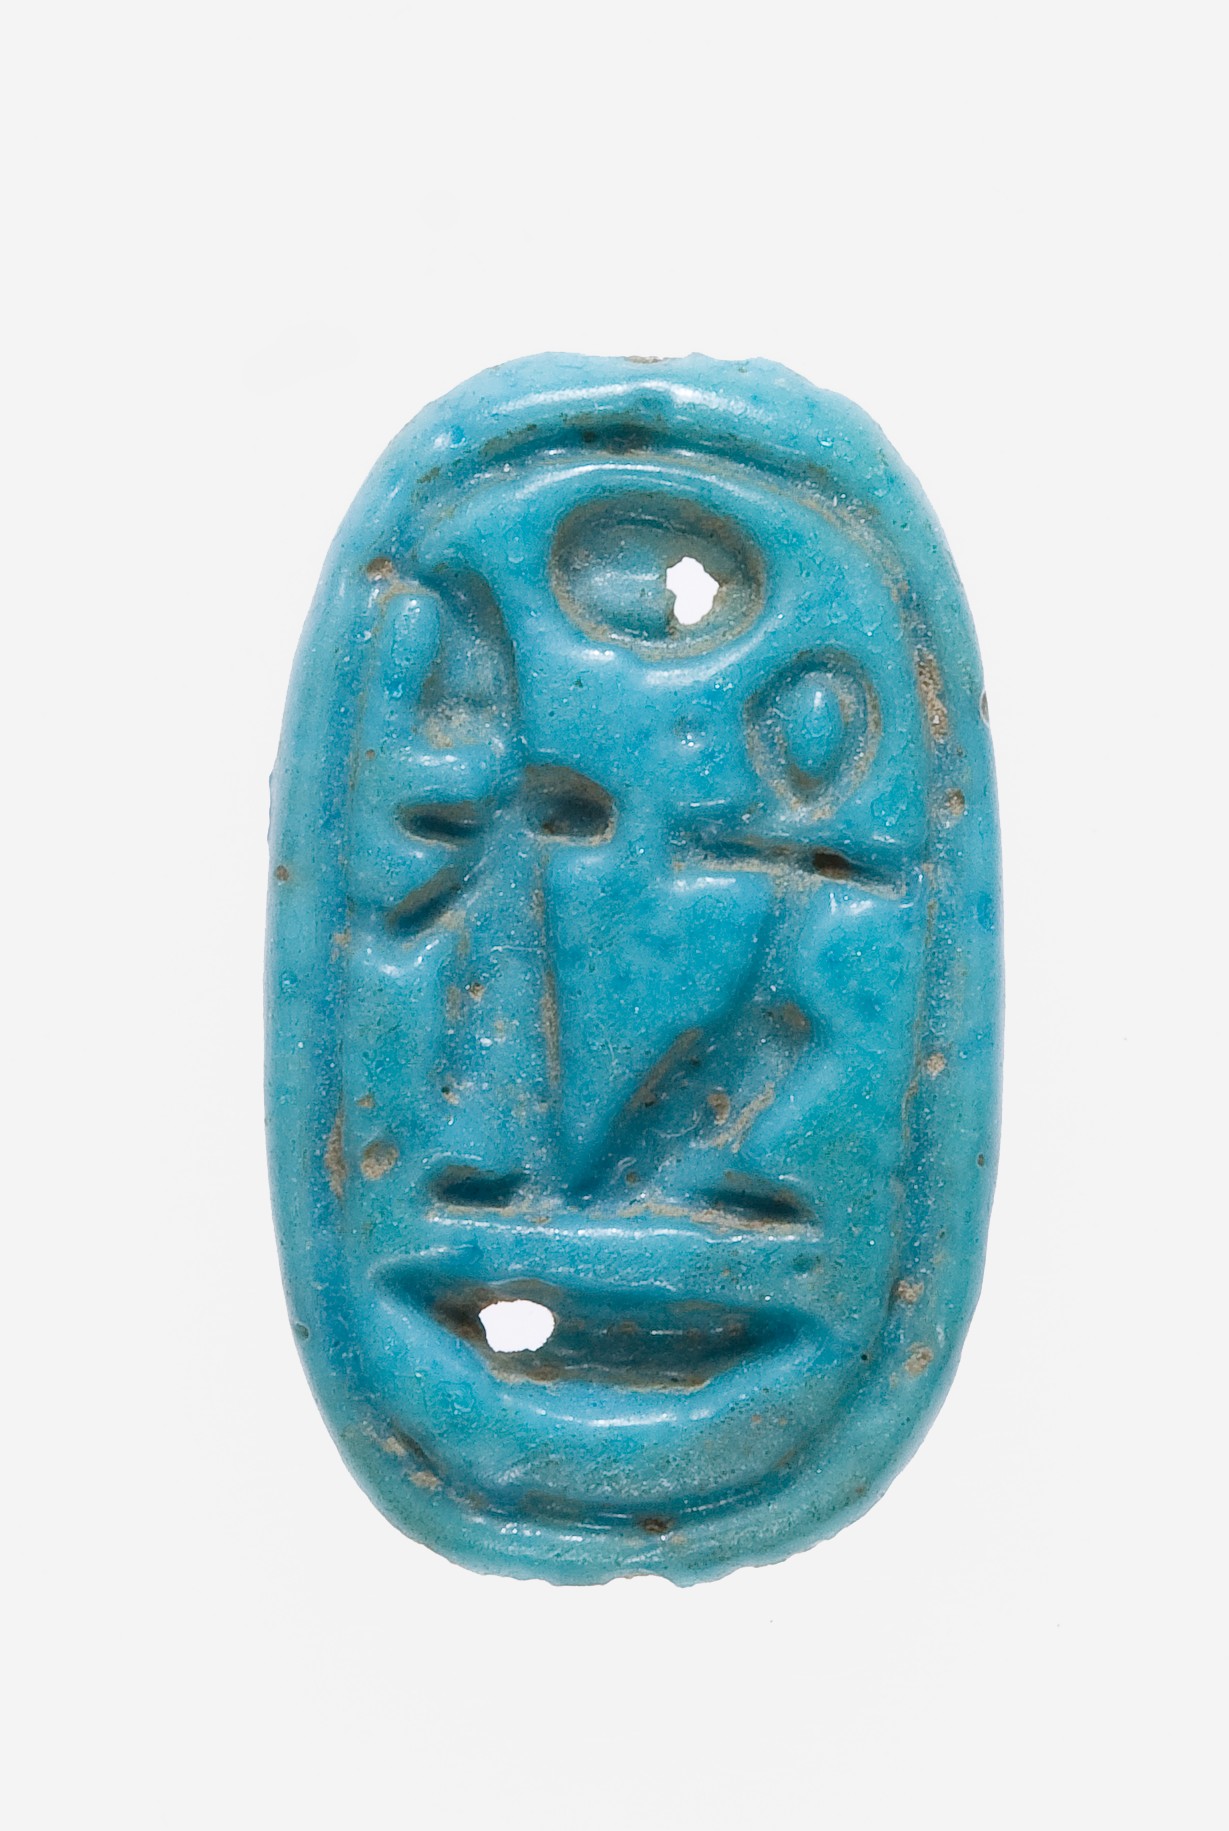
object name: ring, amenhotep iii, nebmaatre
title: Plaque Inscribed with the Throne Name of Amenhotep III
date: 1390-1352 BCE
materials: faience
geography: egypt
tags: hieroglyphs